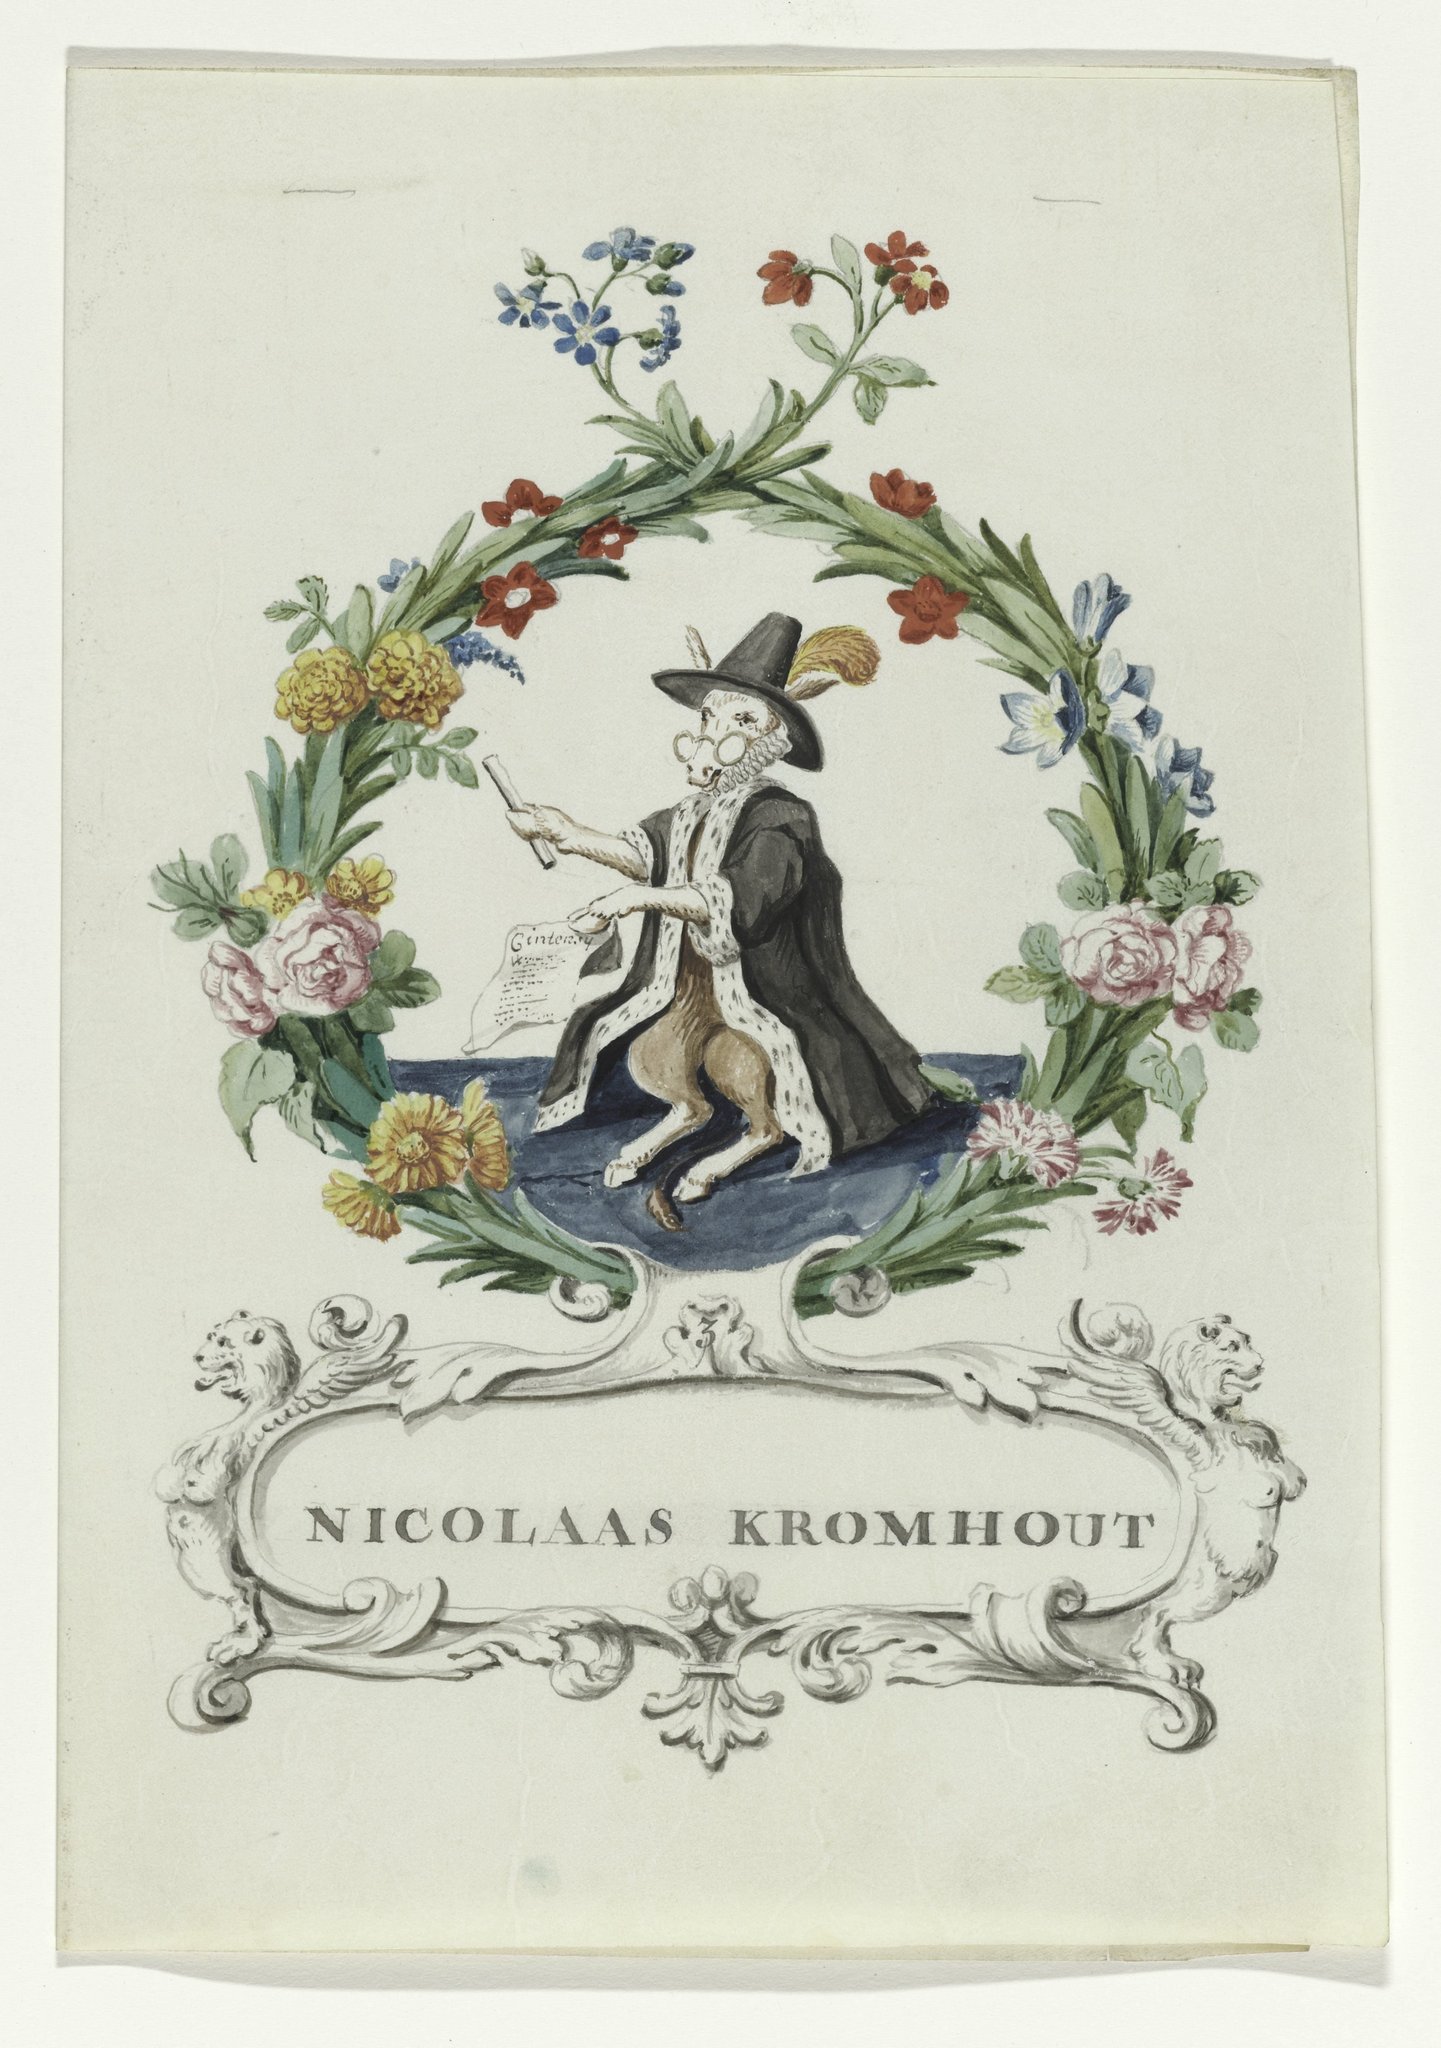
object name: drawing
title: Regtspleging van Oldenbarnevelt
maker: Anonymous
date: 1710-1720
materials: ink, parchment, watercolor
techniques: brush, pen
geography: netherlands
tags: the hague, johan van oldenbarnevelt, ass, donkey, caricatures (human types), historical persons, bad, corrupt judge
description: Spotprent van Nicolaas Kromhout, rechter van Van Oldenbarnevelt. Ezel met mantel, hoed en bril in krans van bloemen en bladeren. Daaronder cartouche met aan weerszijden twee leeuwinnen. In cartouche naam en daarboven nr. 3. Behorende bij serie aquarellen in boek.